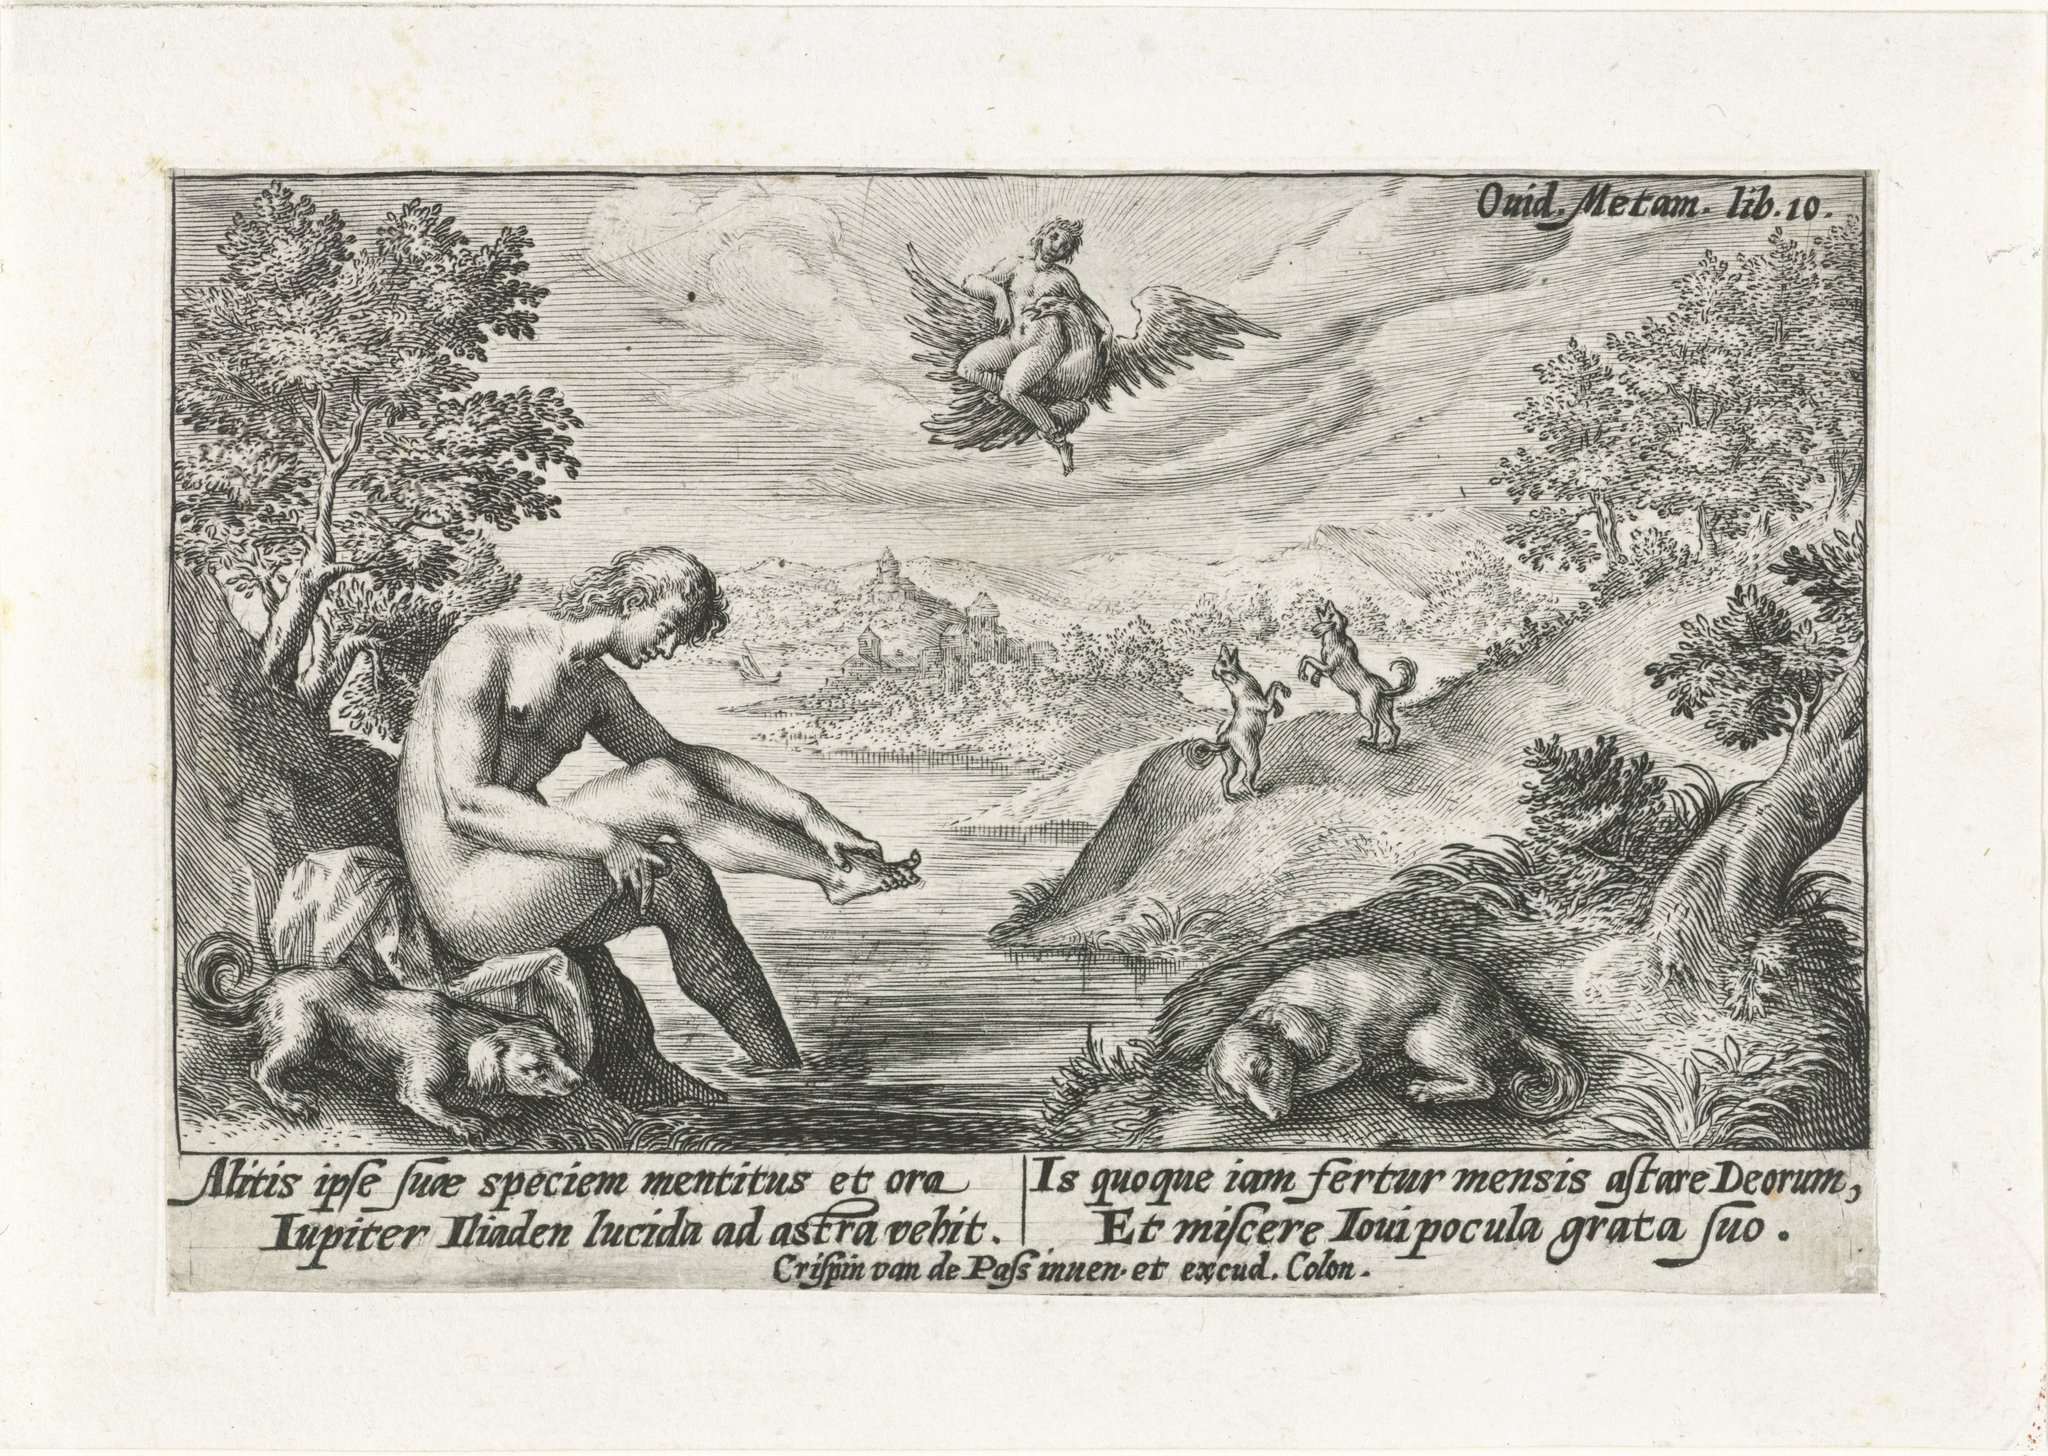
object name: print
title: Jupiter ontvoert Ganymedes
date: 1602-1607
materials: paper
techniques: engraving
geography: cologne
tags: the rape of ganymede: he is carried off through the air by jupiter in the form of an eagle, or by the eagle of jupiter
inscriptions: collector's mark: Lugt 240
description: De herder Ganymedes baadt zich aan de oever van een rivier. Jupiter werd verliefd op hem vanwege zijn uitzonderlijke schoonheid. Op de achtergrond vliegt Jupiter, in de gedaante van een adelaar, met Ganymedes naar de Olympus. In de marge een vierregelig onderschrift, in twee kolommen, in het Latijn.